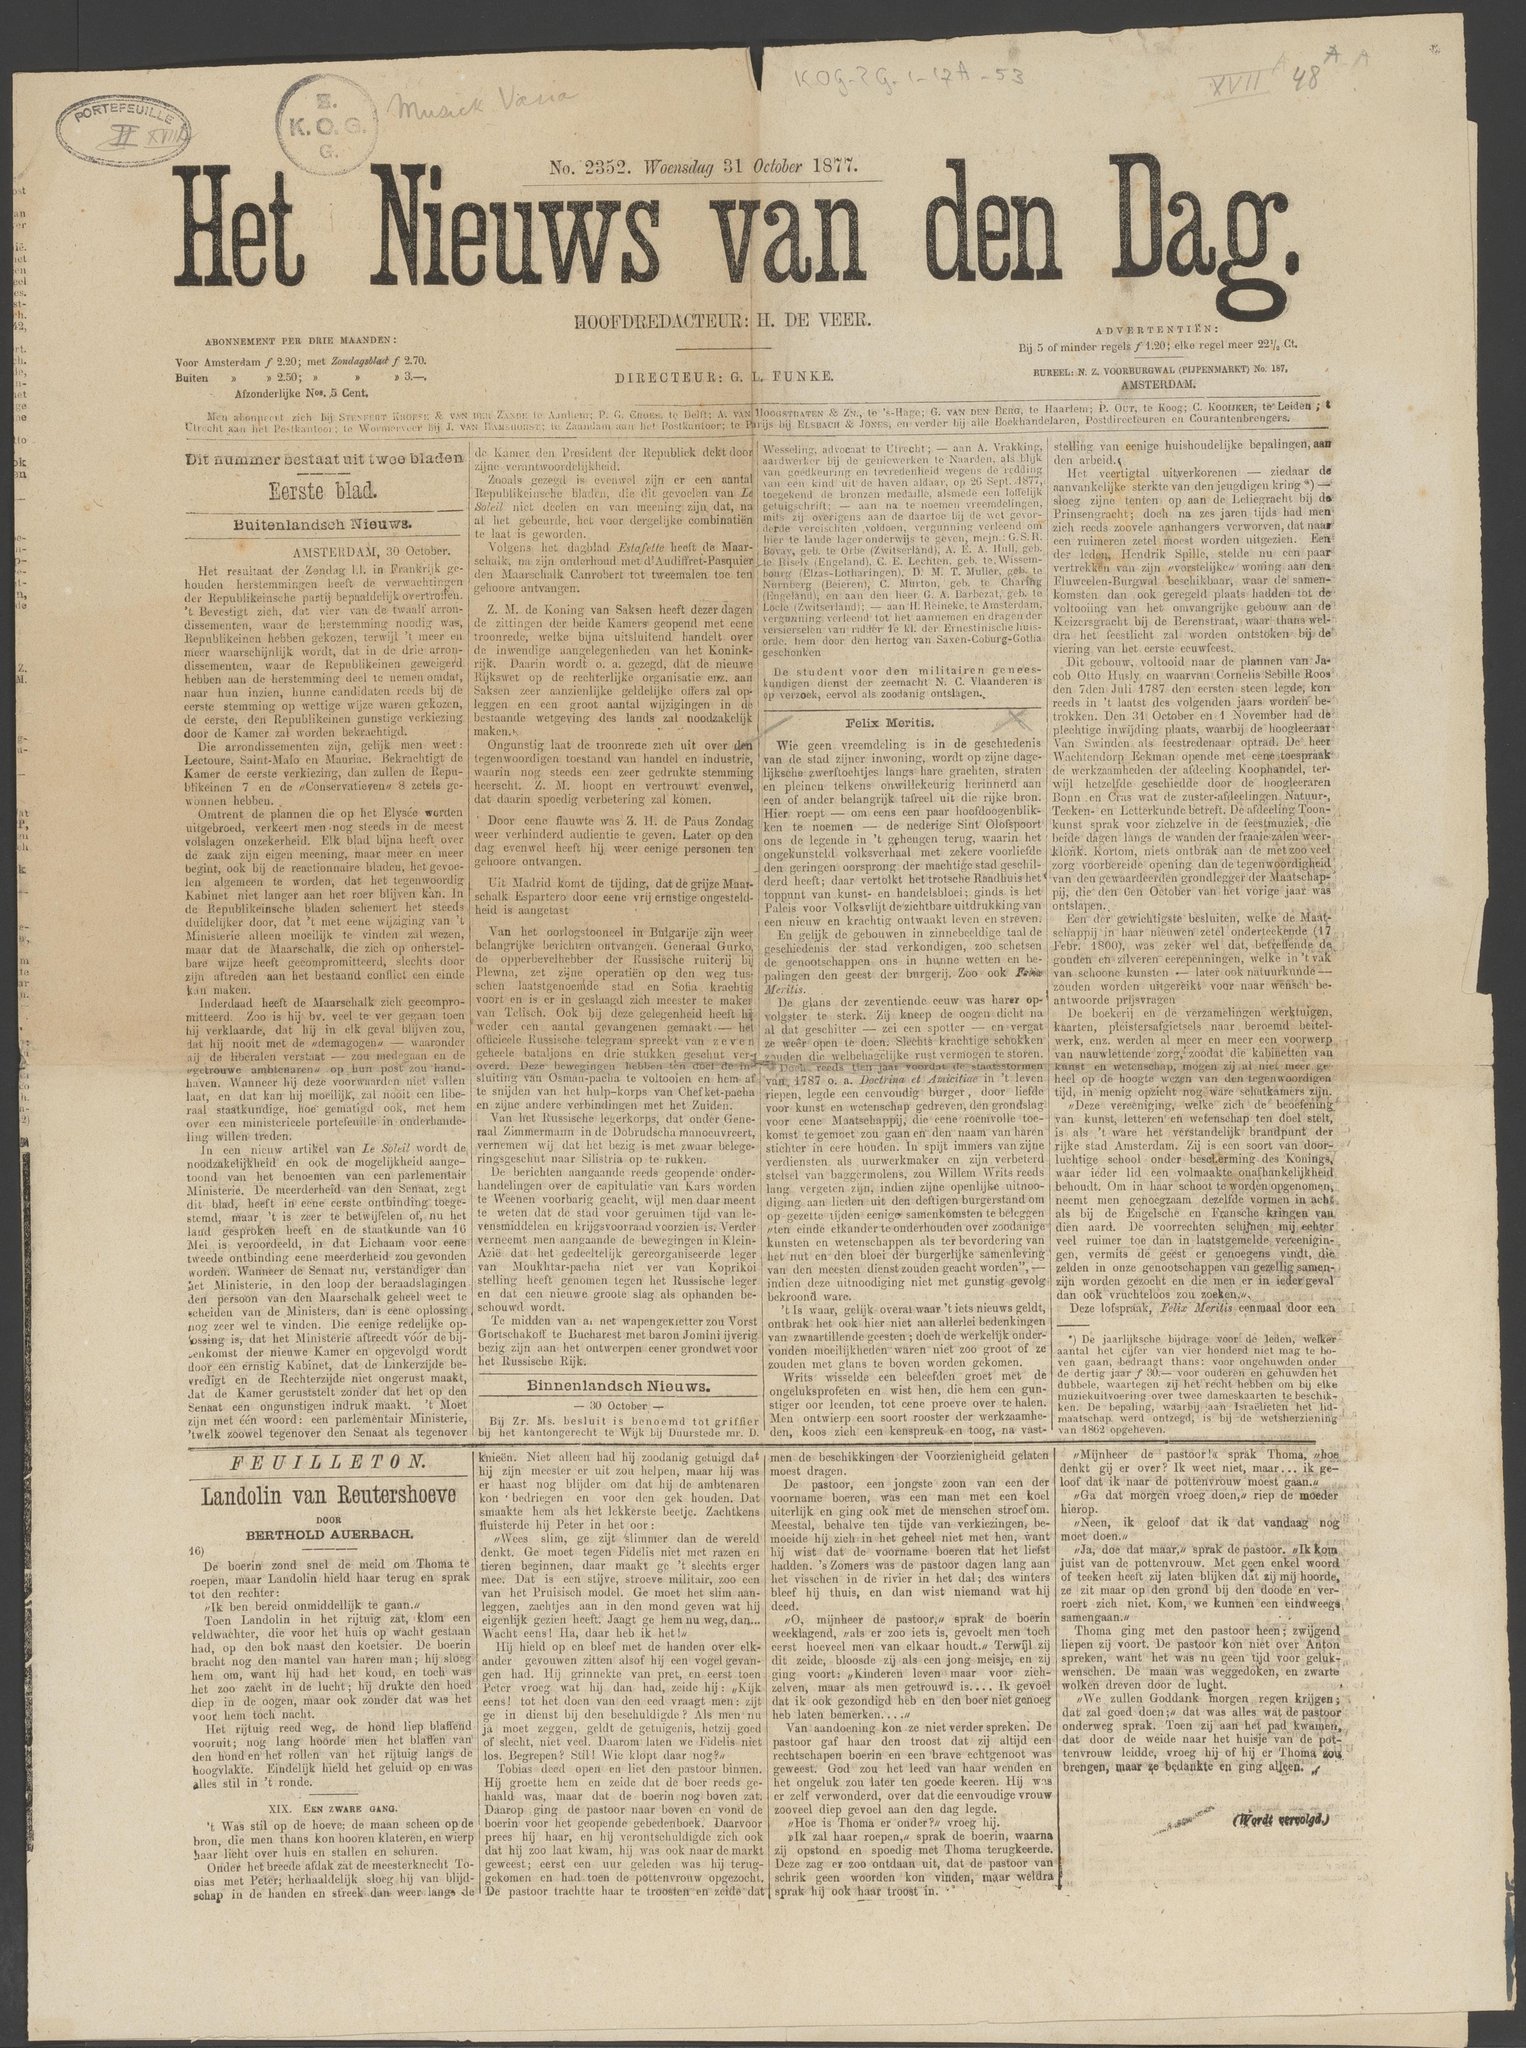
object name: newspaper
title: Het Nieuws van den Dag, woensdag 3 october 1877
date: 1877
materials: paper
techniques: printing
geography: amsterdam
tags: concert hall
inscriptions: collector's mark: Lugt 1641, collector's mark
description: Exemplaar van de krant Het Nieuws van den Dag, van woensdag 3 oktober 1877, met op de voorpagina een artikel over Felix Meritis naar aanleiding van het 100-jarig bestaan. Onderwerpsrubrieken binnen de Atlas Zeden en Gewoonten: Muziek en muziekinstrumenten: Concertzalen.